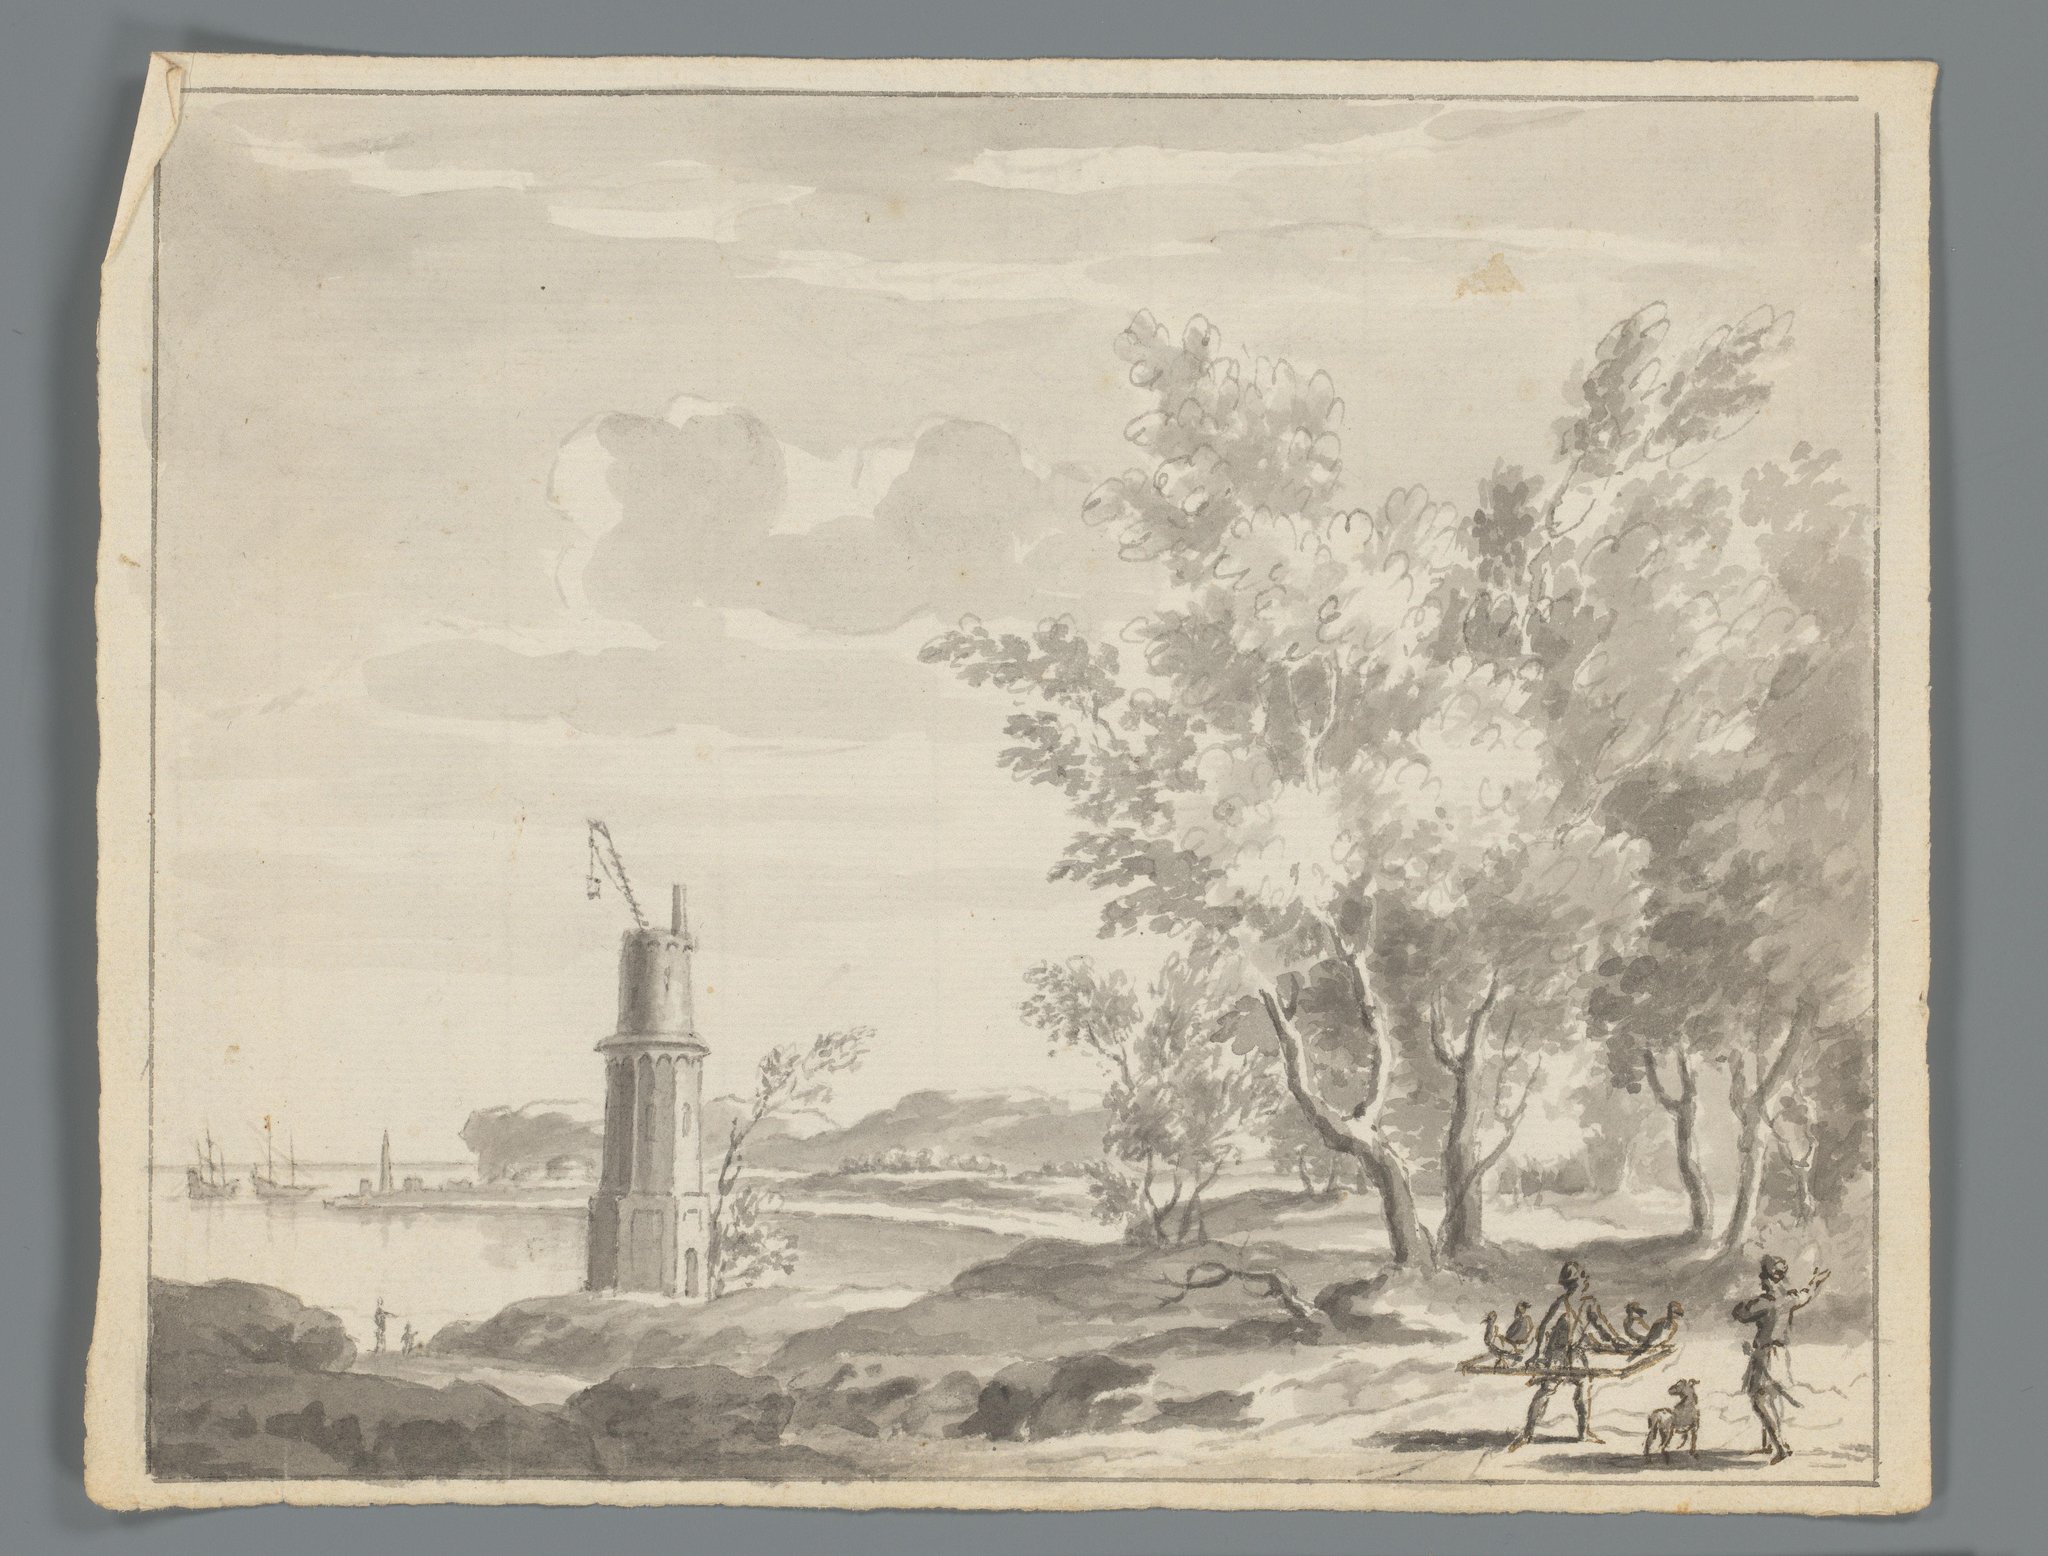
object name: drawing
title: Landschap met water, een toren, twee figuren waarvan één een rek met vogels draagt en een hond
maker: matthijs balen (1684-1766)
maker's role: draughtsman, painter, print maker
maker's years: 1684-1766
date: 1694-1766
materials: paper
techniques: brush, pen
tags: tower, clock tower ~ monumental adornment, birds, landscapes with waters, waterscapes, seascapes (in the temperate zone), dog